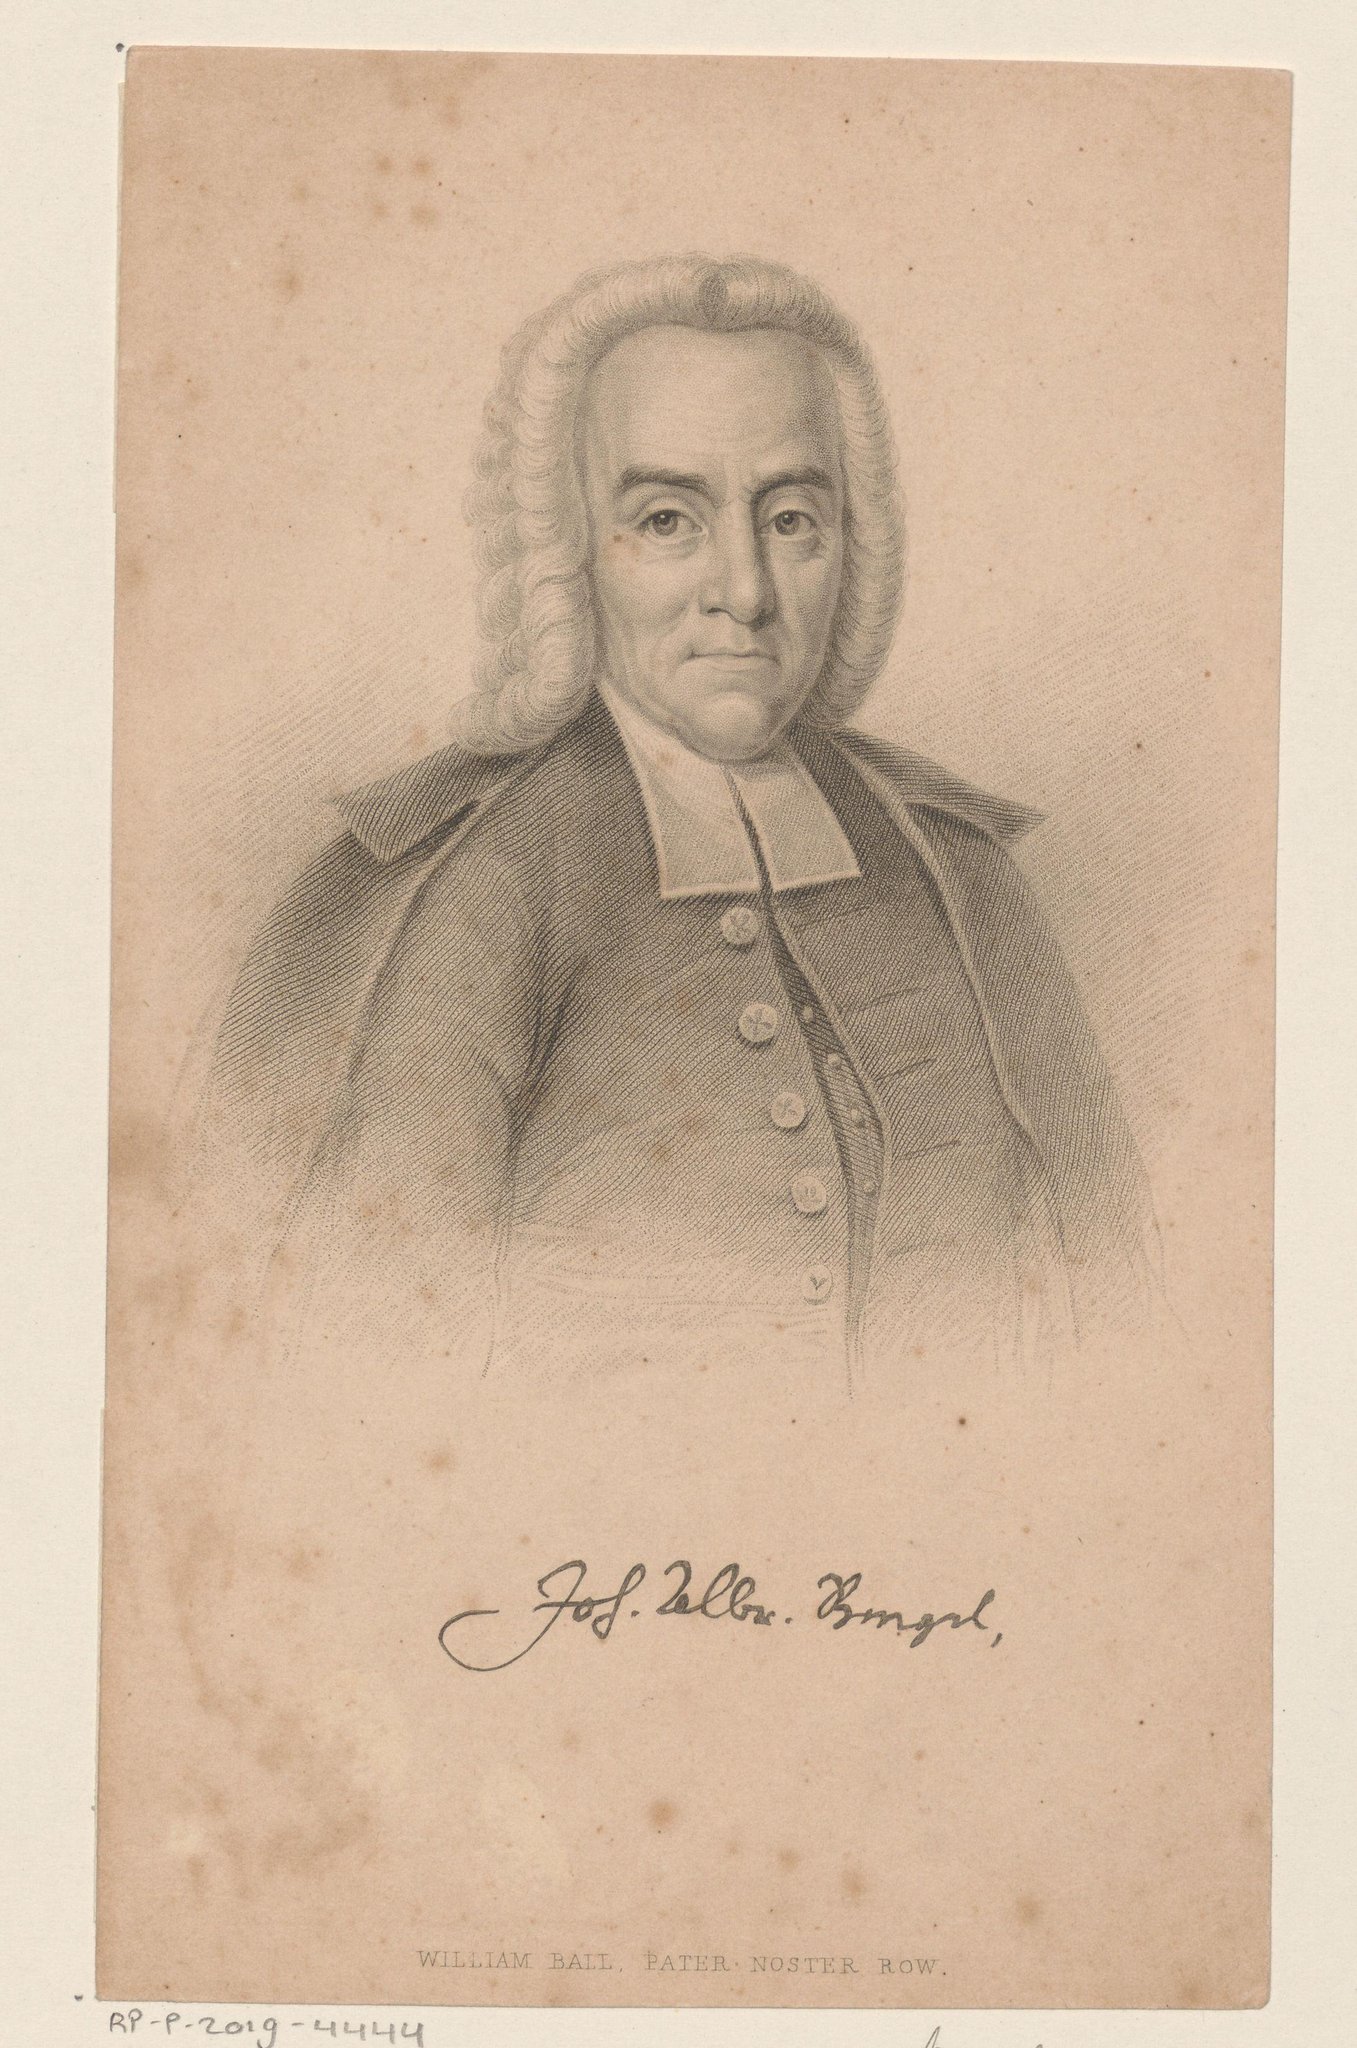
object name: print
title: Portret van Johann Albrecht Bengel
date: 1836-1841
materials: paper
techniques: etching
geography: london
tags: historical persons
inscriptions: collector's mark: Lugt 2228